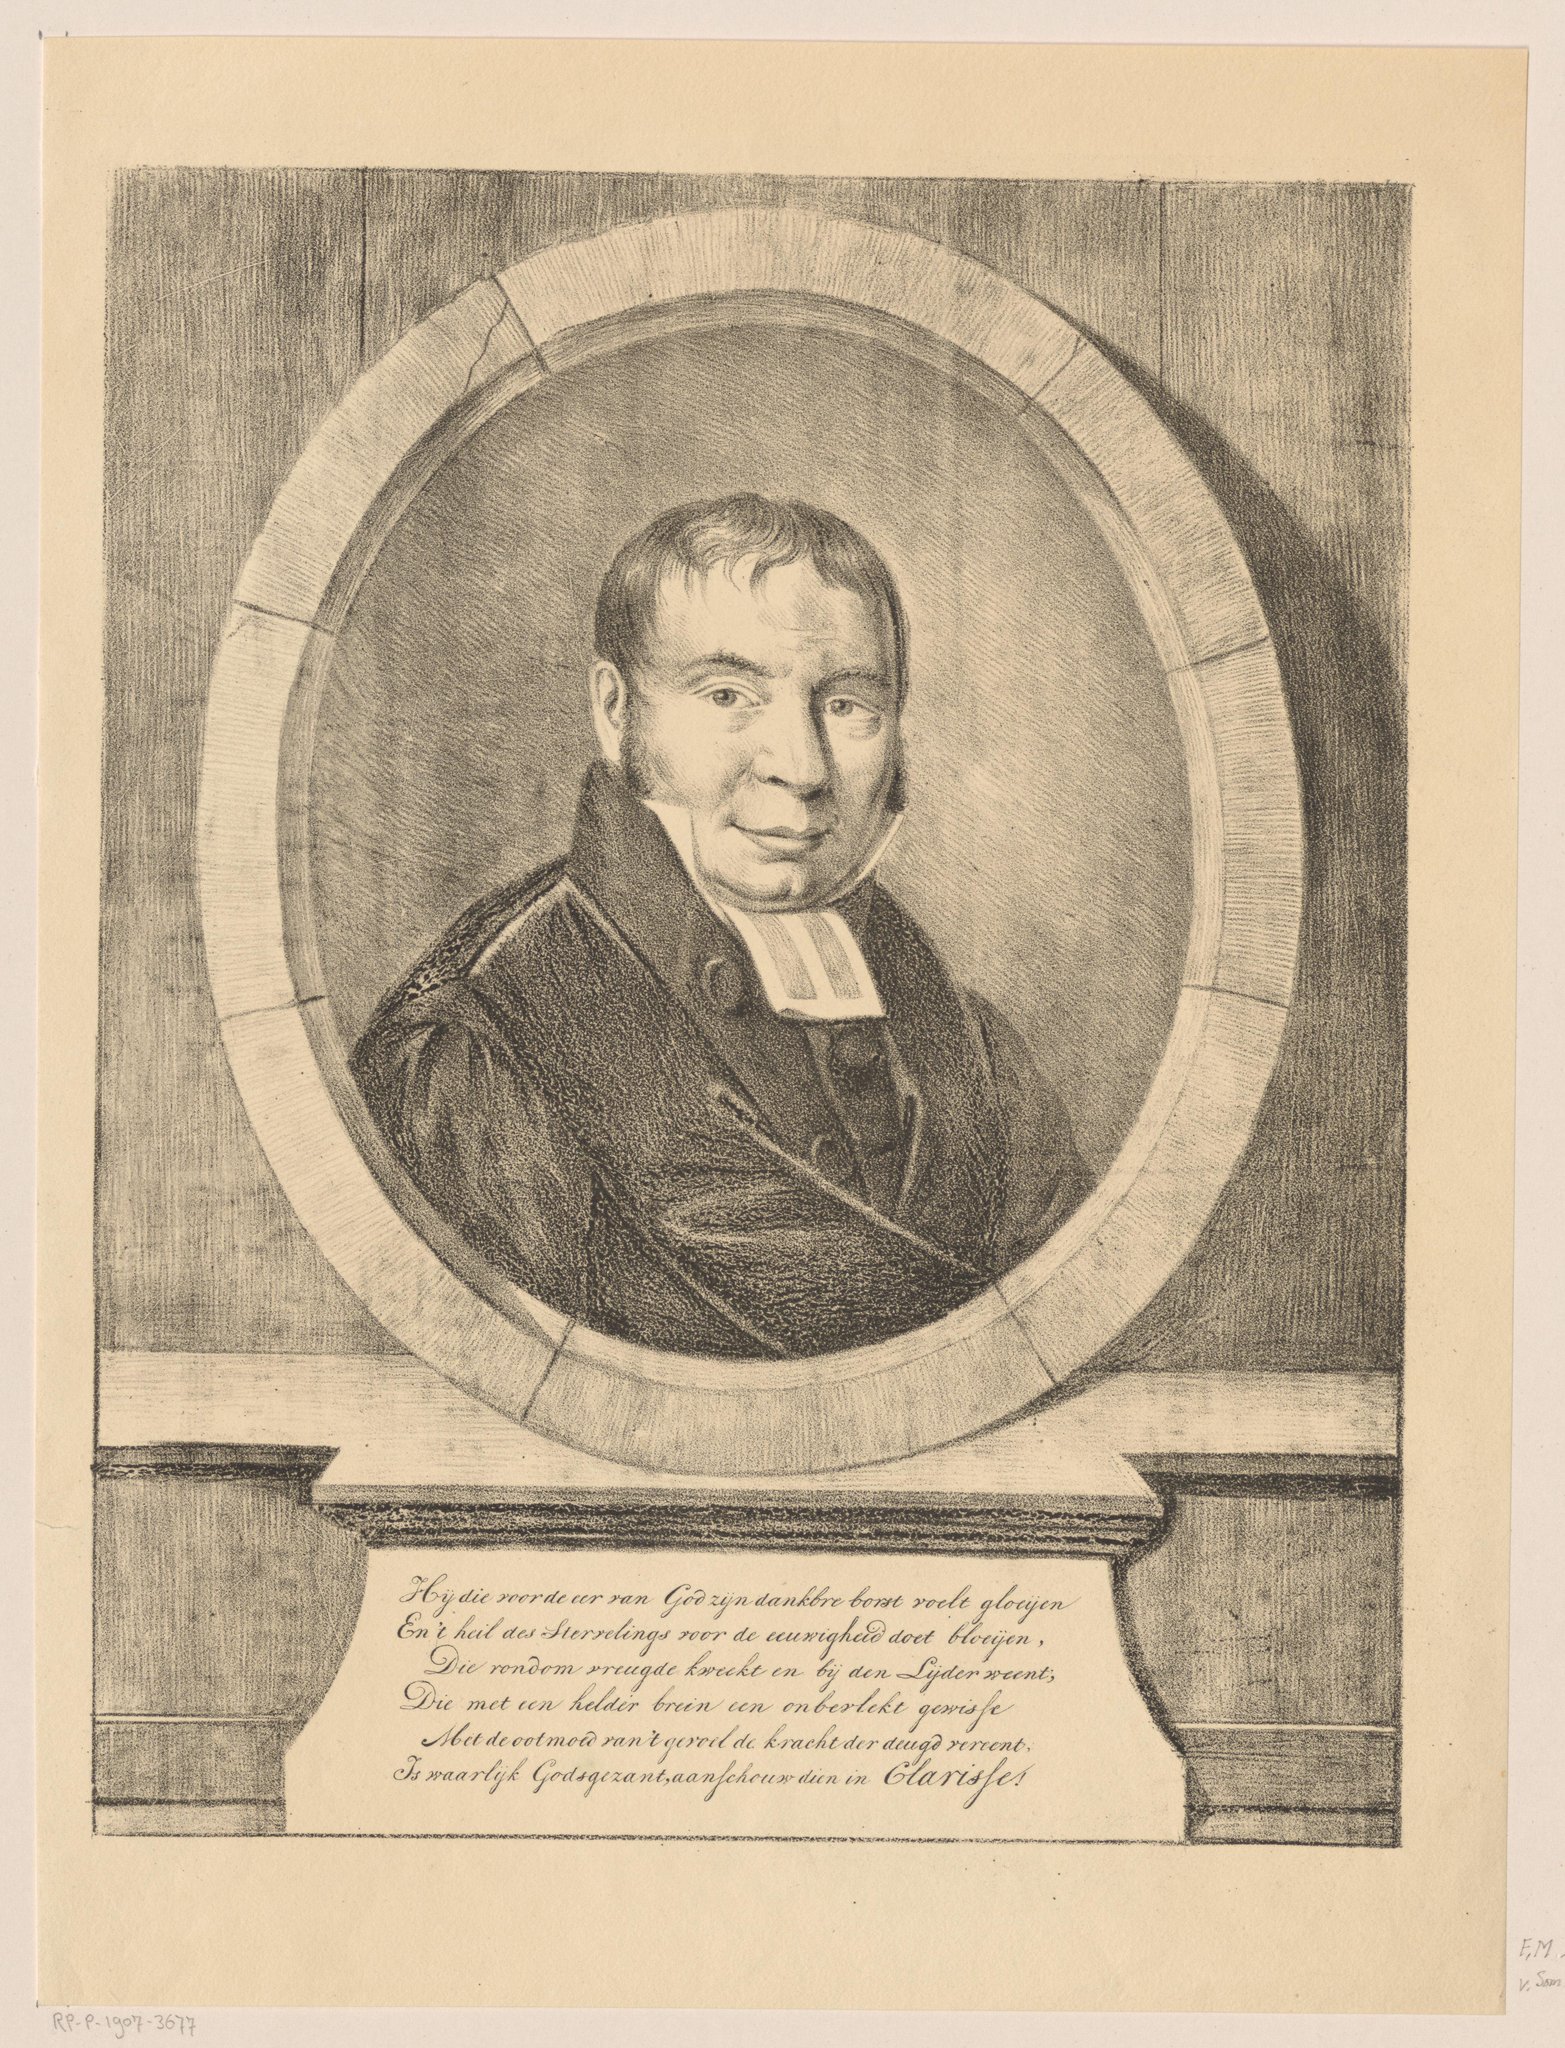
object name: print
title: Portret van Johannes Clarisse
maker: Anonymous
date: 1800-1899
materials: paper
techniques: lithograph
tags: rhenen, historical persons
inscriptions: collector's mark: Lugt 2228